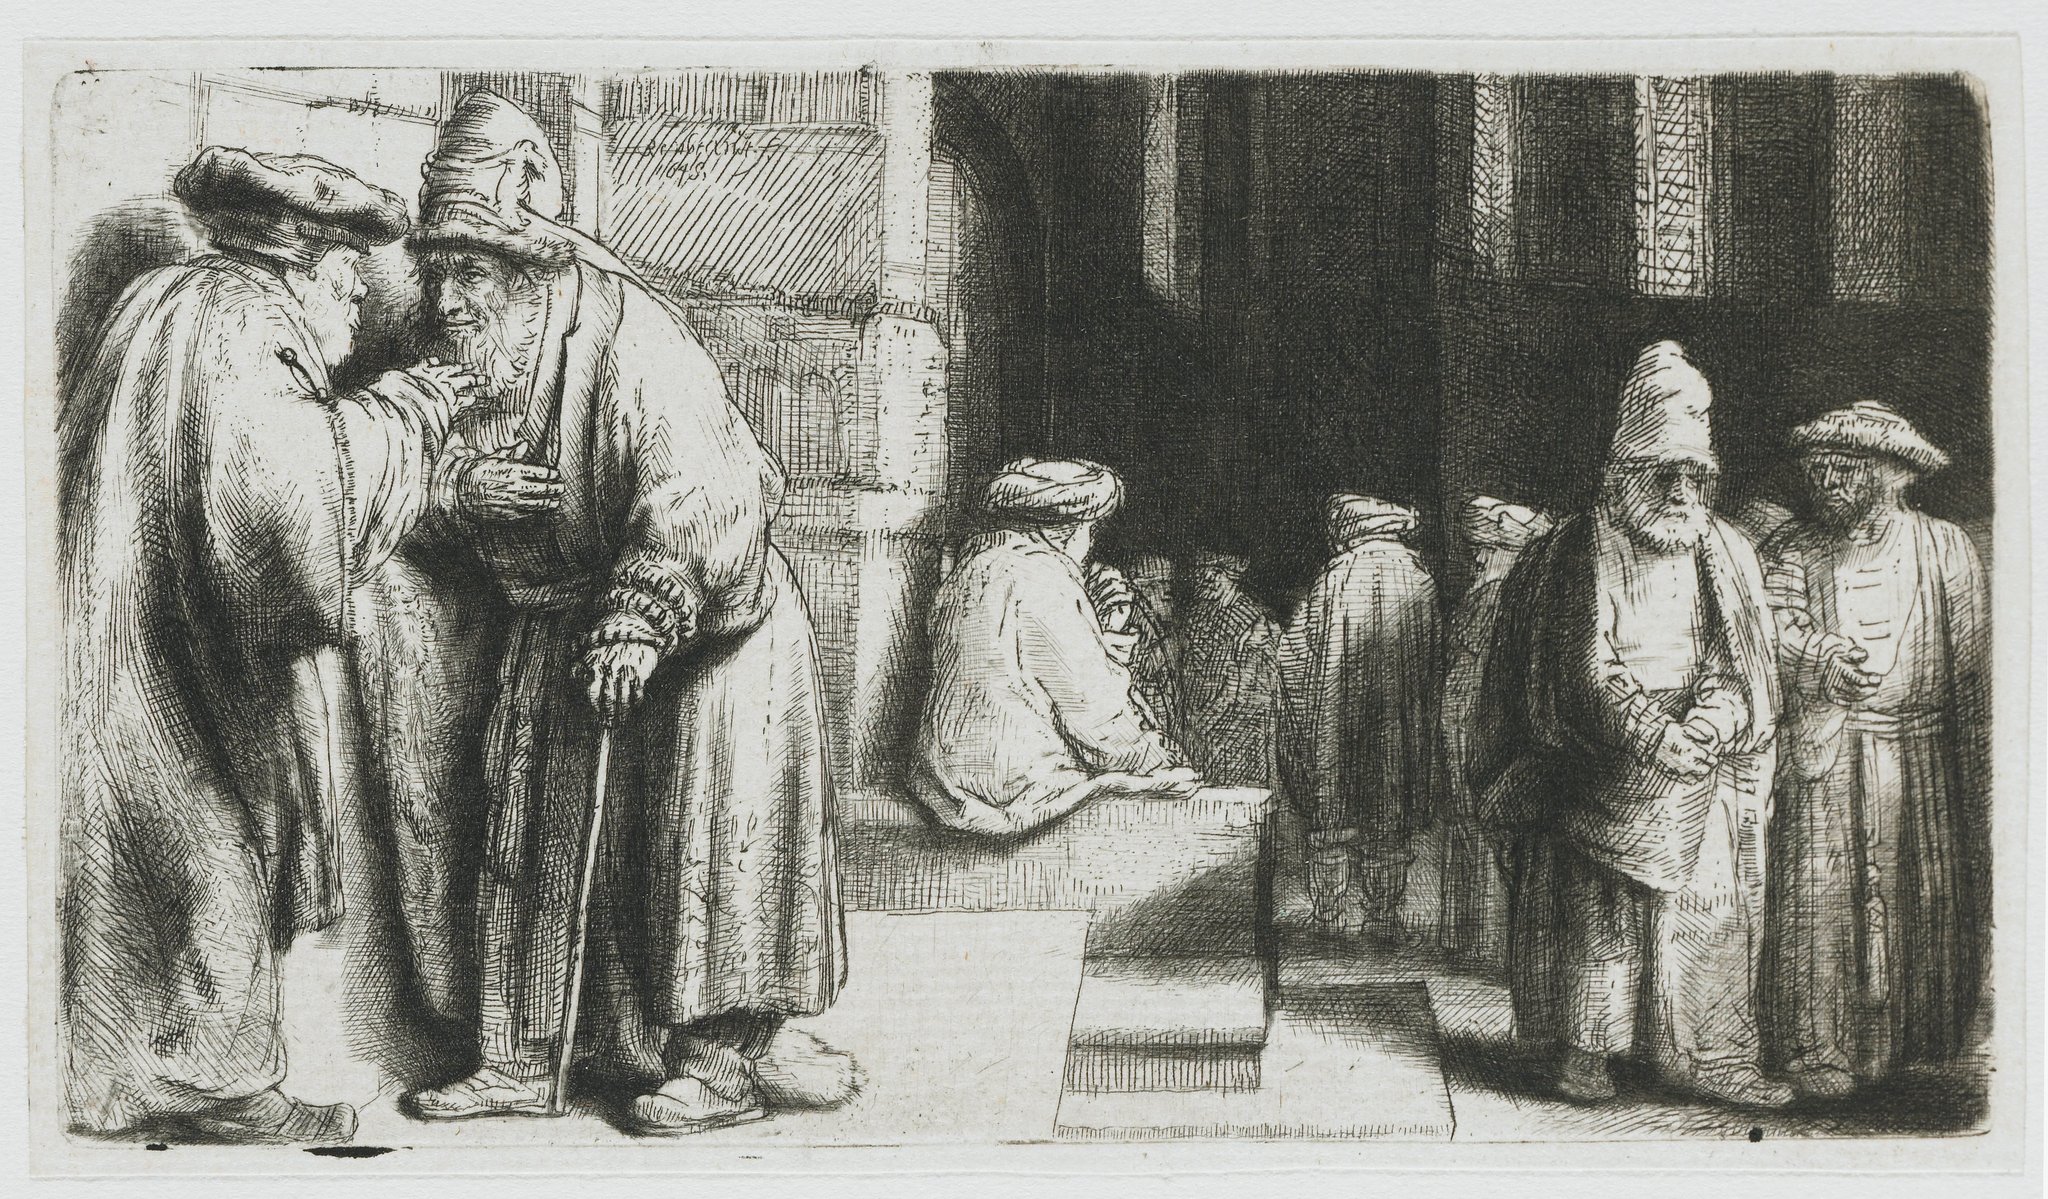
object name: print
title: Jews in the synagogue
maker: rembrandt van rijn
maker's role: draughtsman, painter, print maker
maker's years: 1606-1669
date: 1648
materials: paper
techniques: drypoint, etching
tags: the praying pharisee and the repentant publican in the temple (luke 18:10-14)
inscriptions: signature and date: ‘Rembrandt f. 1648’, collector's mark: Lugt 240